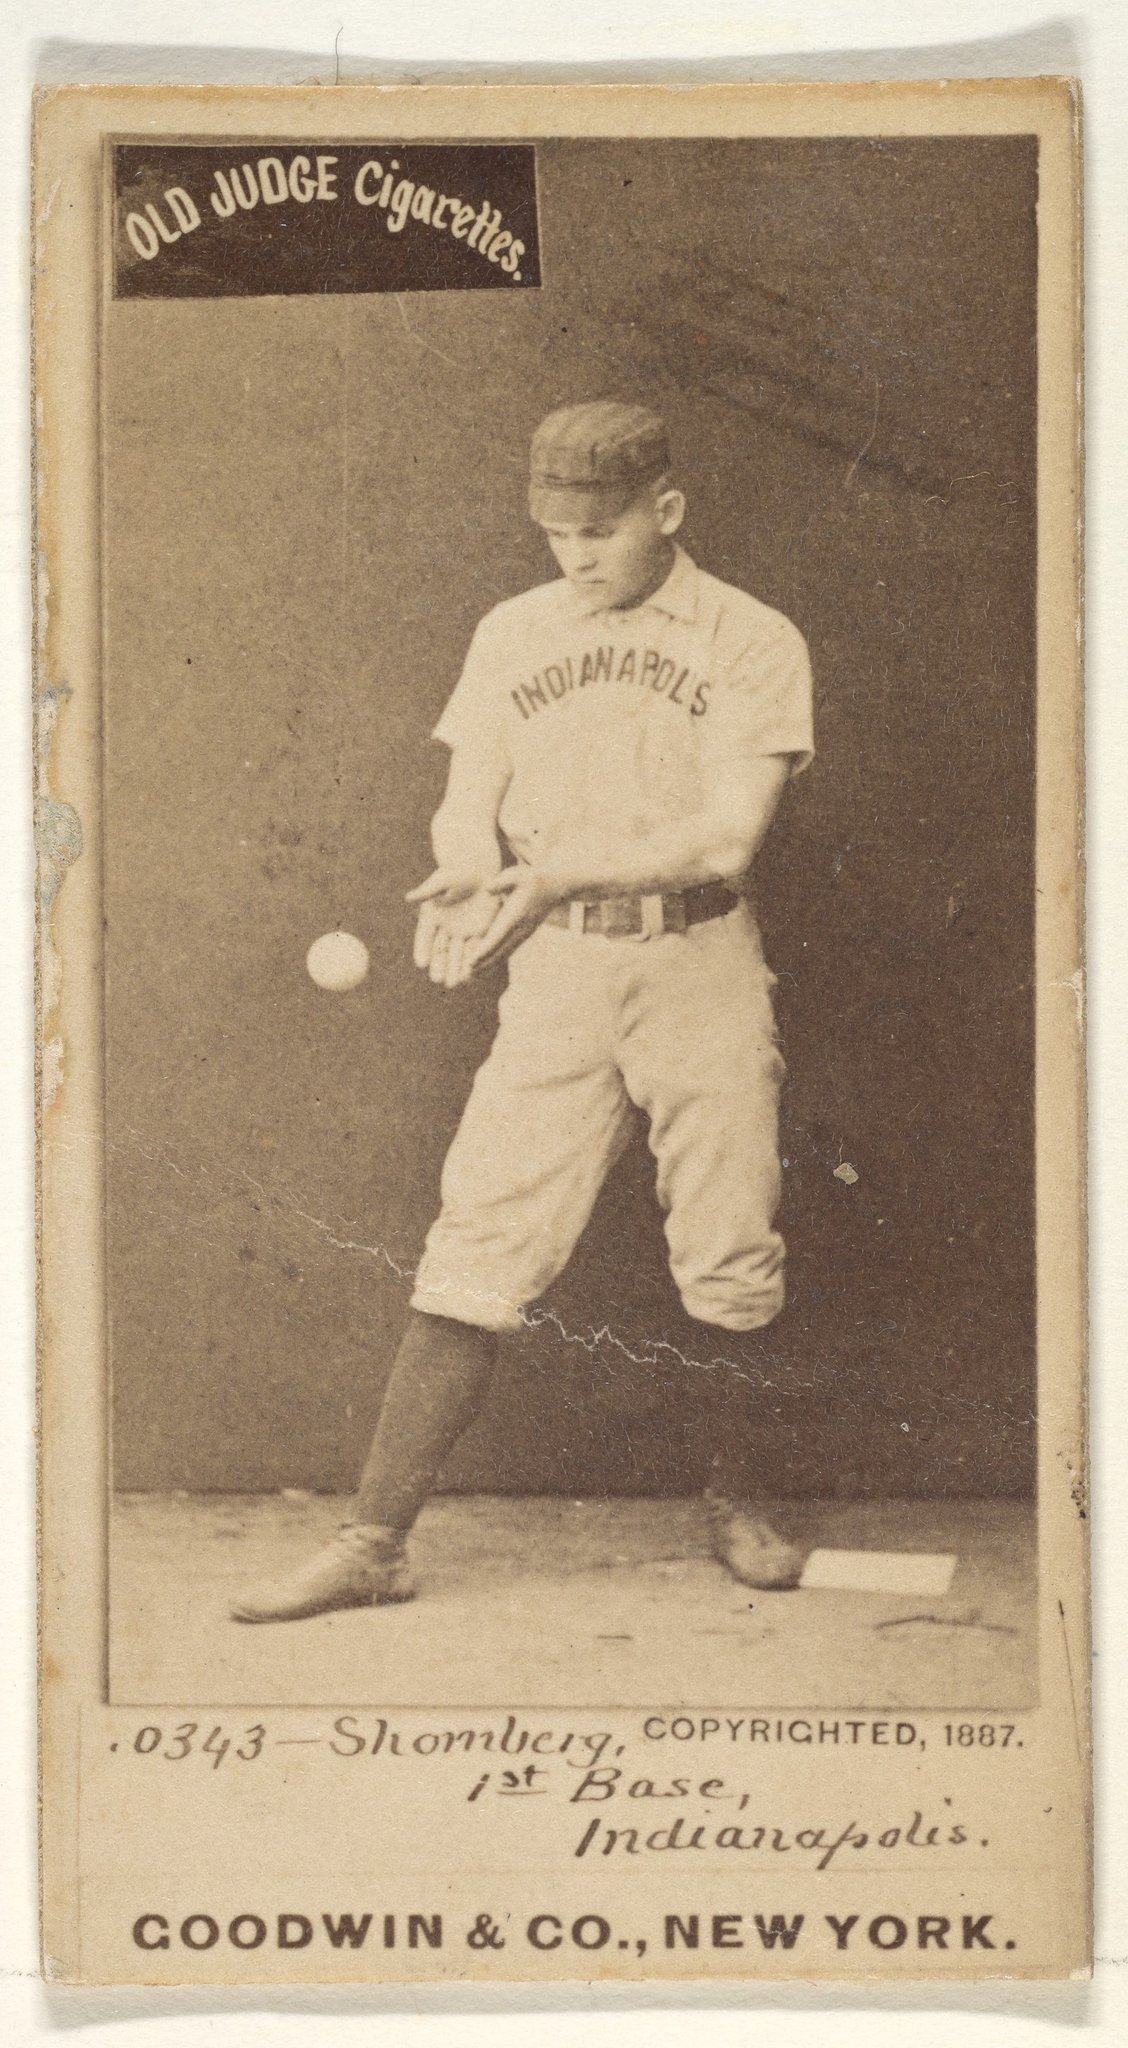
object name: baseball card, photograph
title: Shomberg, 1st Base, Indianapolis, from the Old Judge series (N172) for Old Judge Cigarettes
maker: goodwin & company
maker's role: publisher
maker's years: 1850-1950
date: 1887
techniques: albumen silver print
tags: men,portraits,baseball,athletes